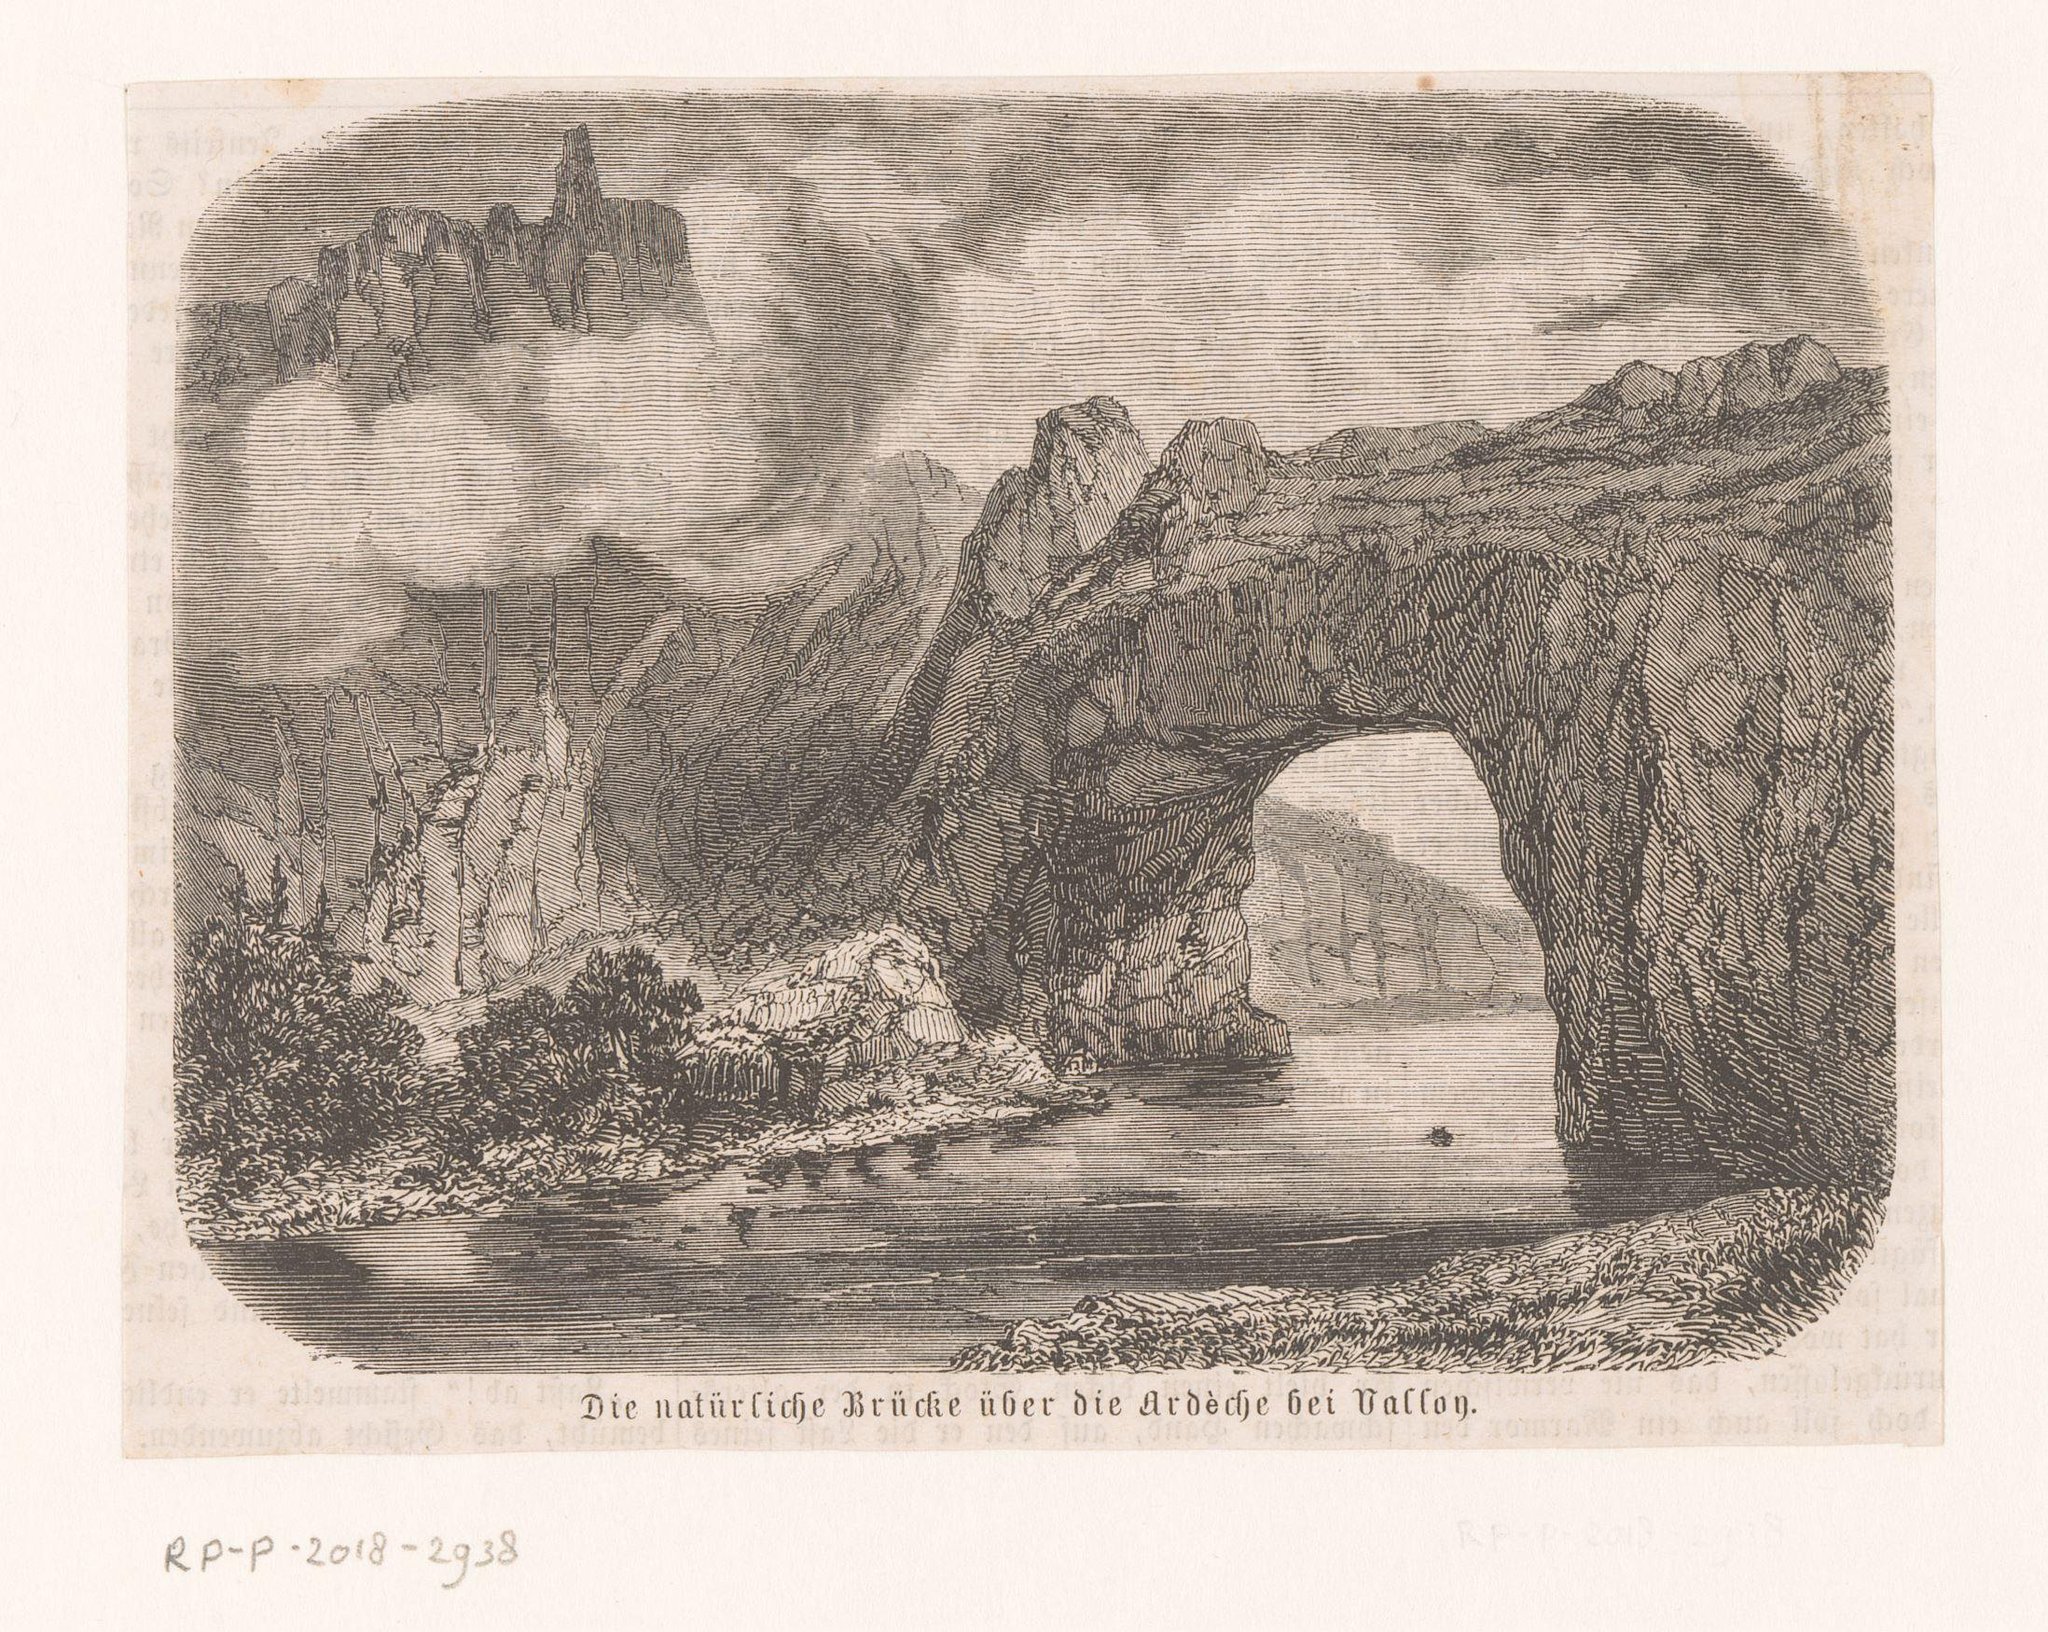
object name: print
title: Die natürliche Brücke über die Ardèche bei Vallon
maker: Anonymous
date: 1850-1890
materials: paper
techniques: letterpress printing, engraving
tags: rock-formations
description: Vallon-Pont-d'Arc is een rotsformatie die een natuurlijke brug over de rivier de Ardèche vormt.